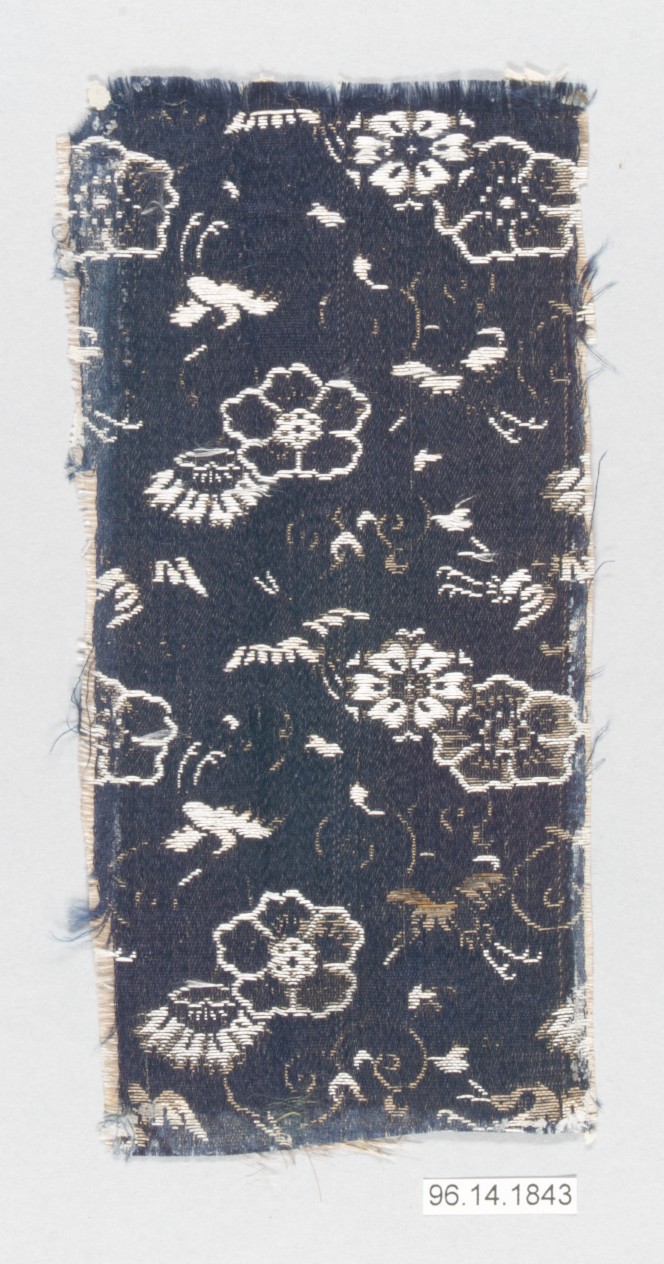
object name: piece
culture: japanese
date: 1701-1900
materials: silk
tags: flowers